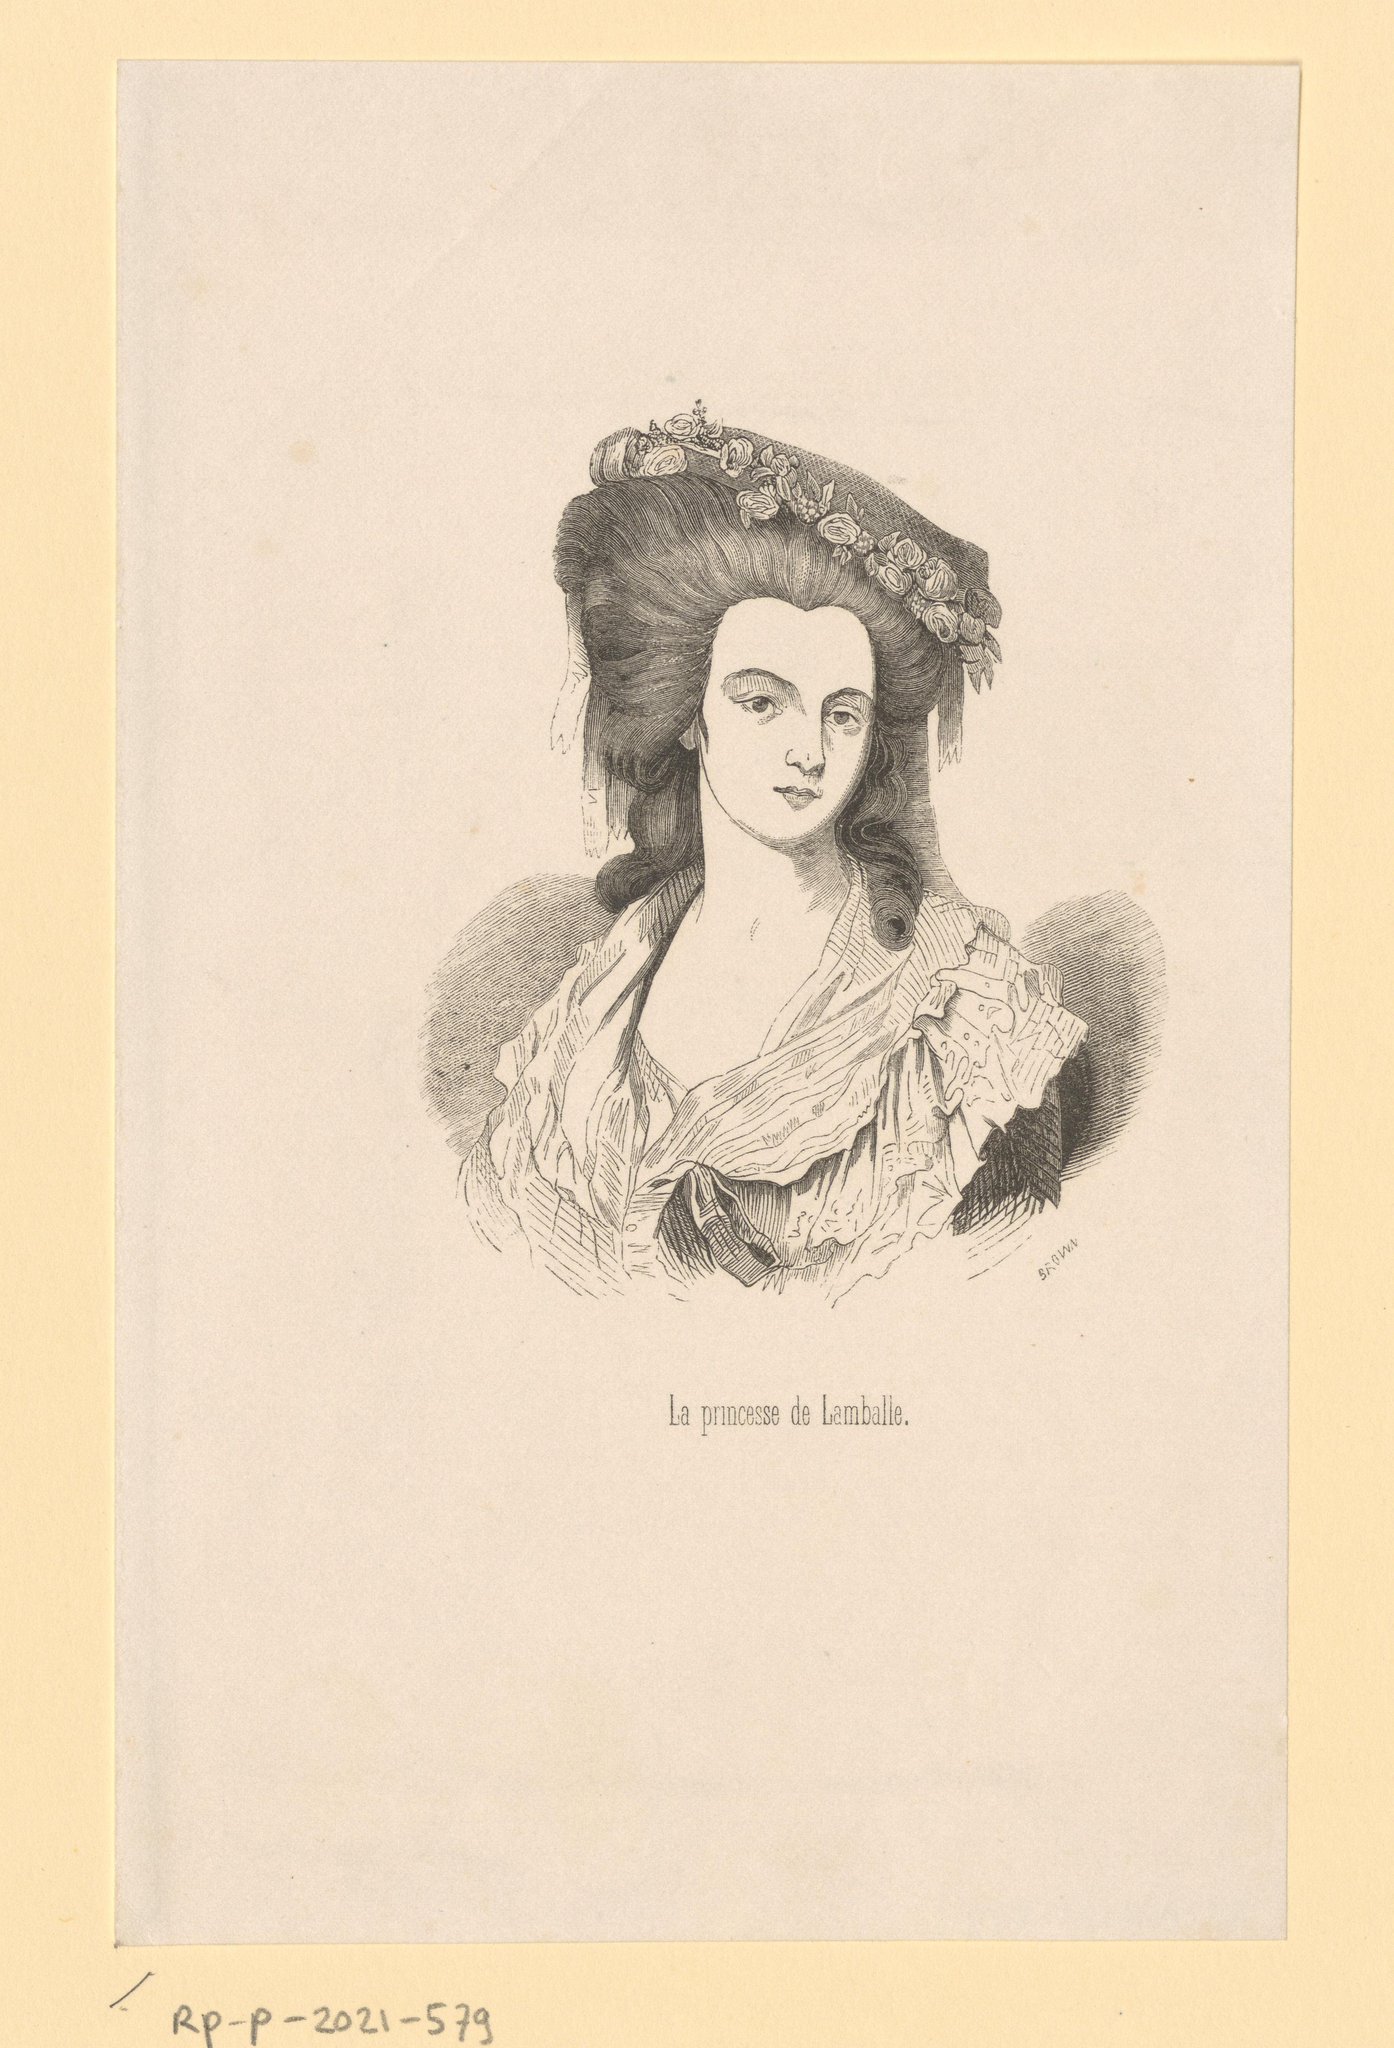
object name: print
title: Portret van Maria Louise van Savoye, prinses van Lamballe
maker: henry brown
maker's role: print maker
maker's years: 1816-1870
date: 1826-1870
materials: paper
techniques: engraving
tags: paris, historical persons - bb - woman